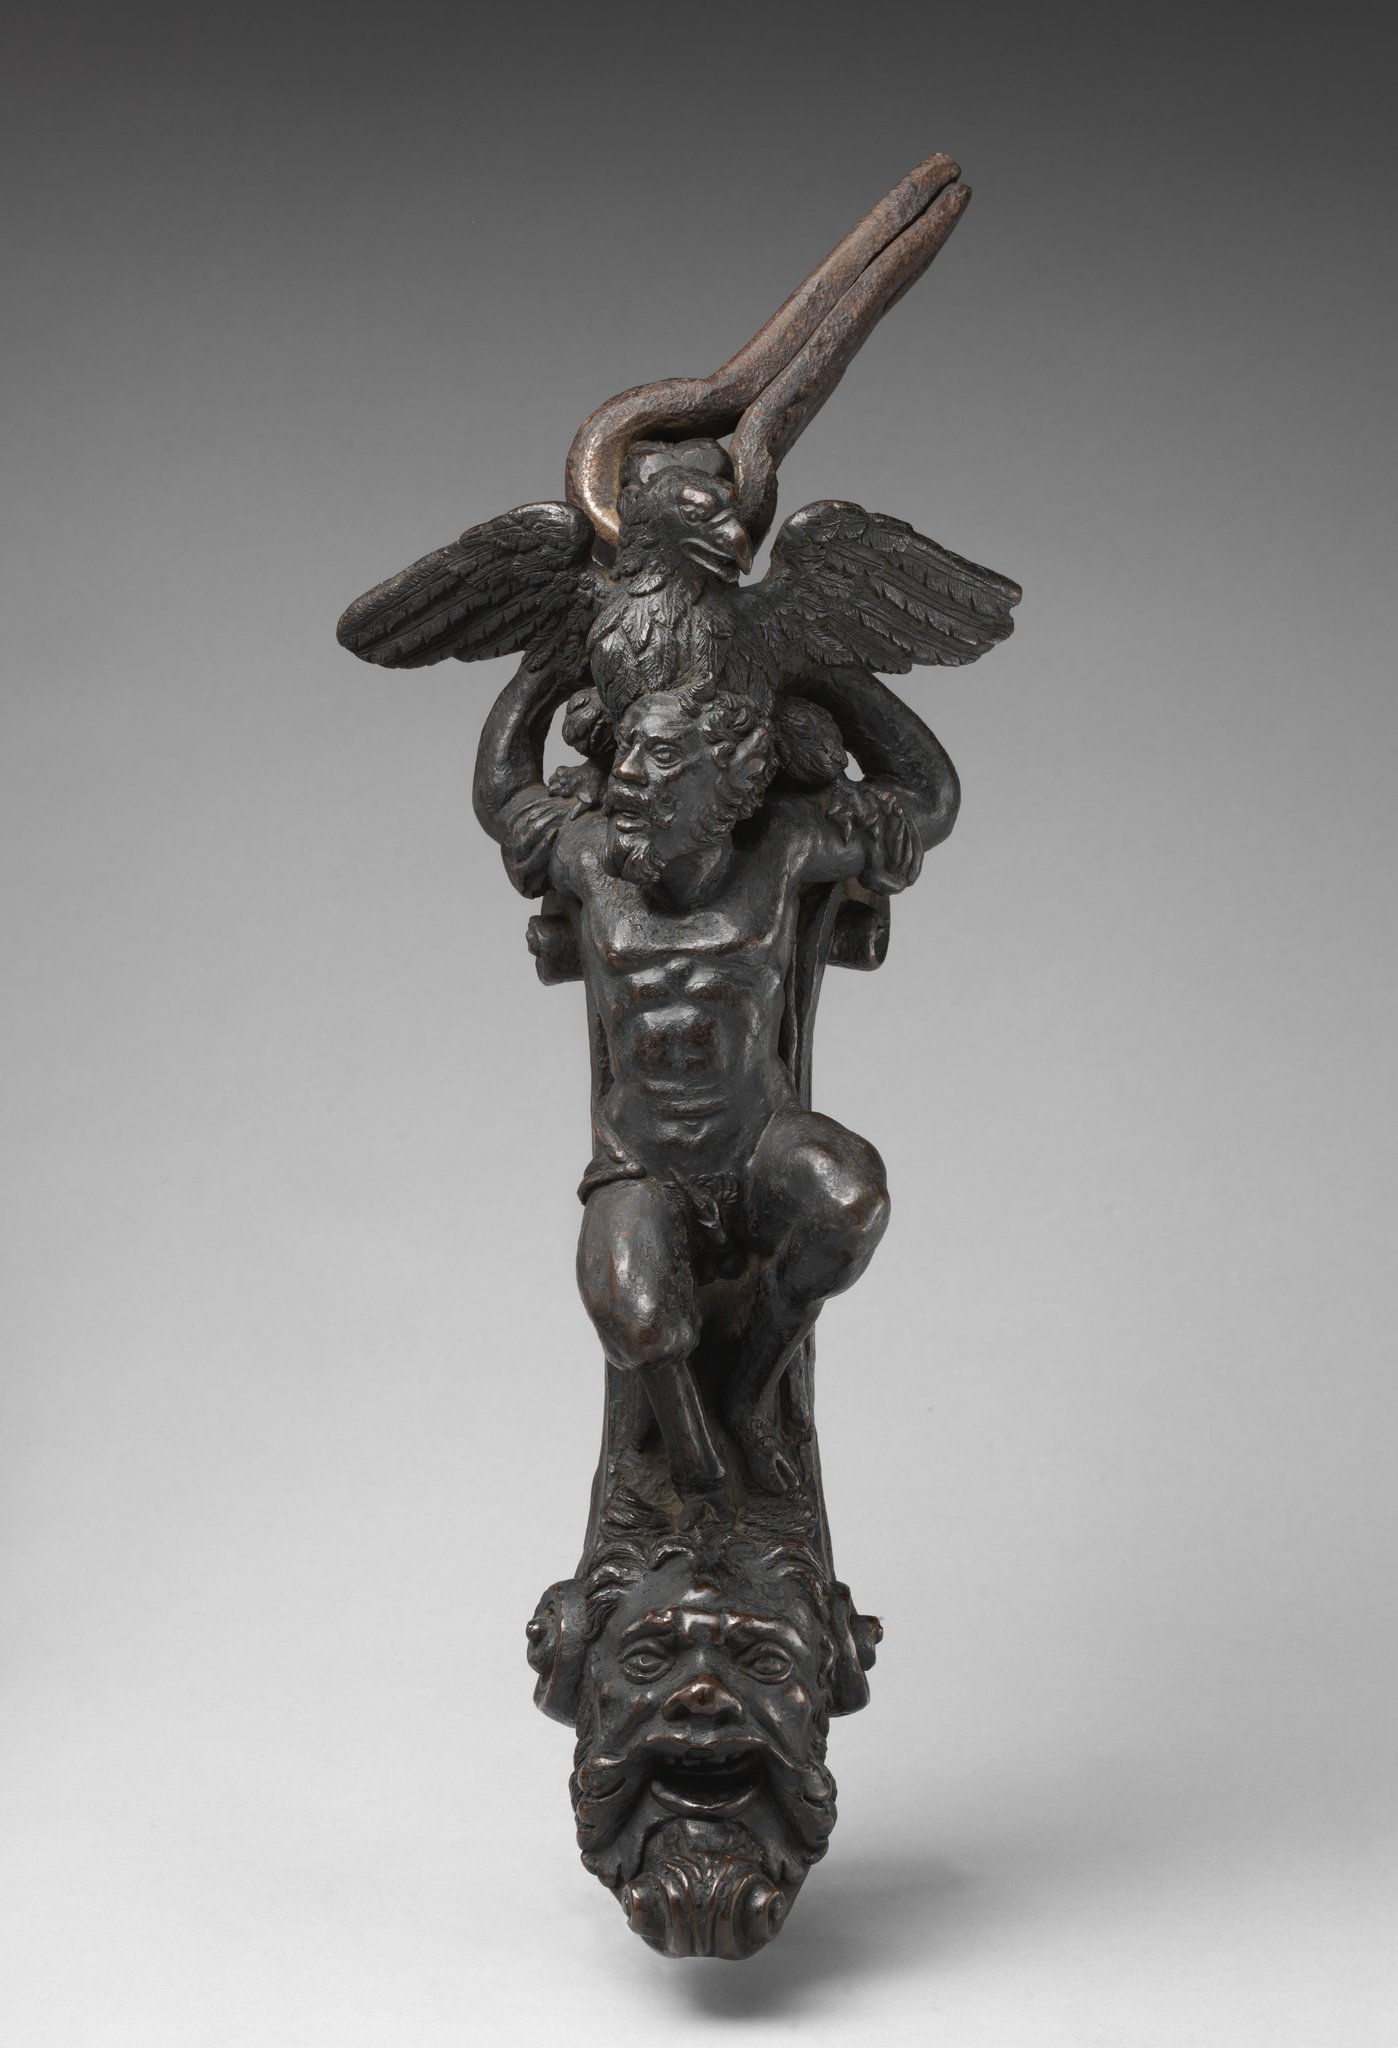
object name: door knocker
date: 1534-1566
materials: bronze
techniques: painting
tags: eagles,faces,men